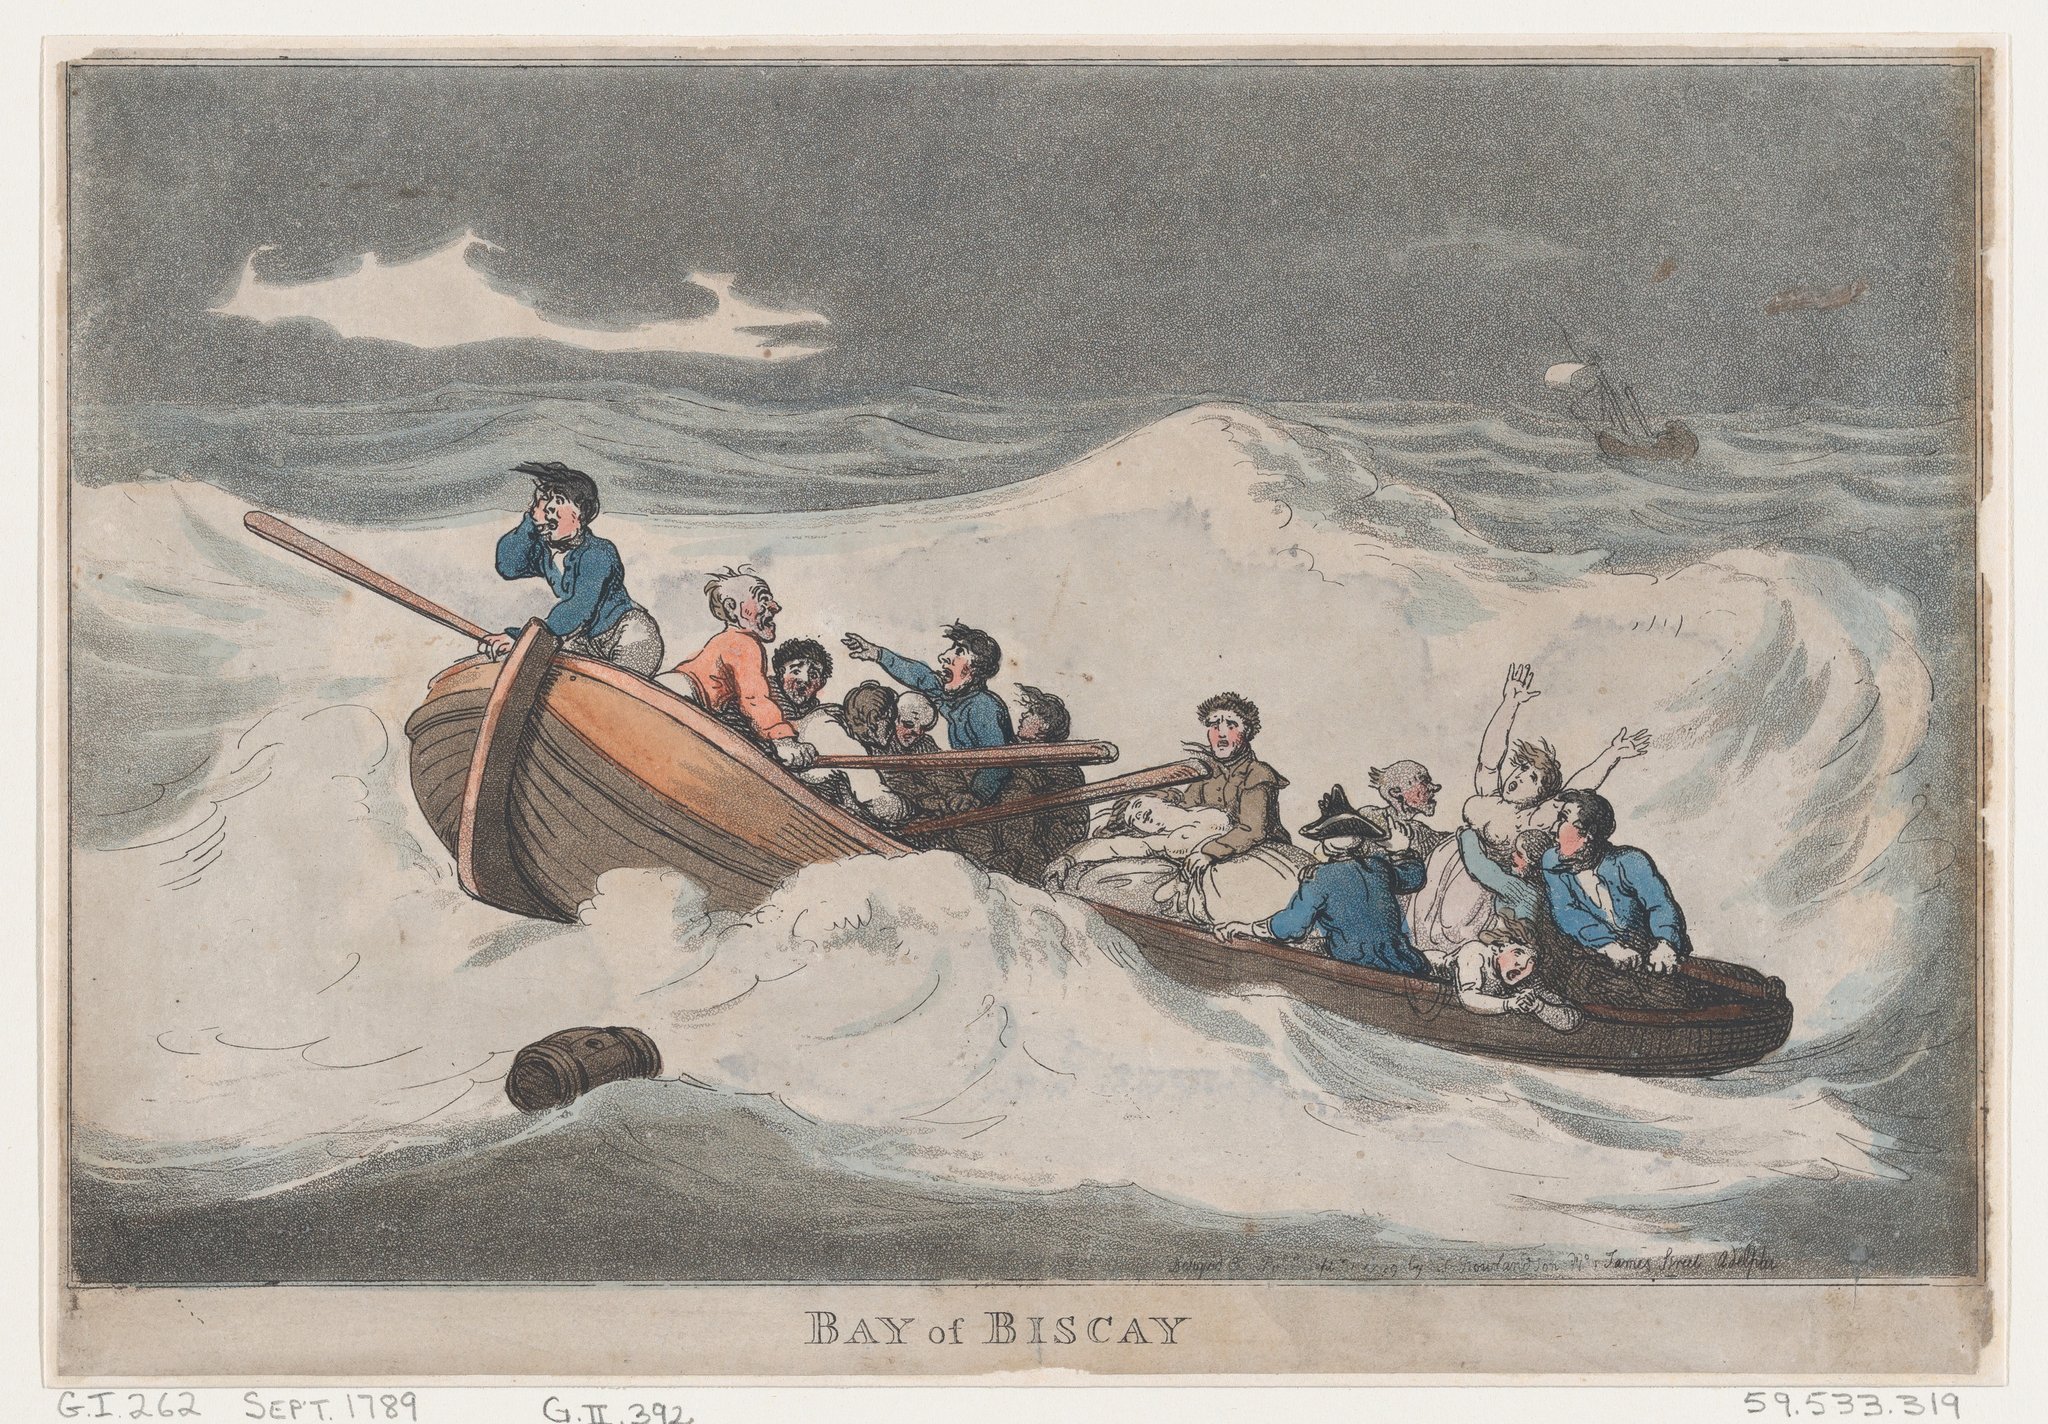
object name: print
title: Bay of Biscay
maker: thomas rowlandson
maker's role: artist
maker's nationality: british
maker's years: 1757-1827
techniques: aquatint, etching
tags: fear,men,women,waves,boats